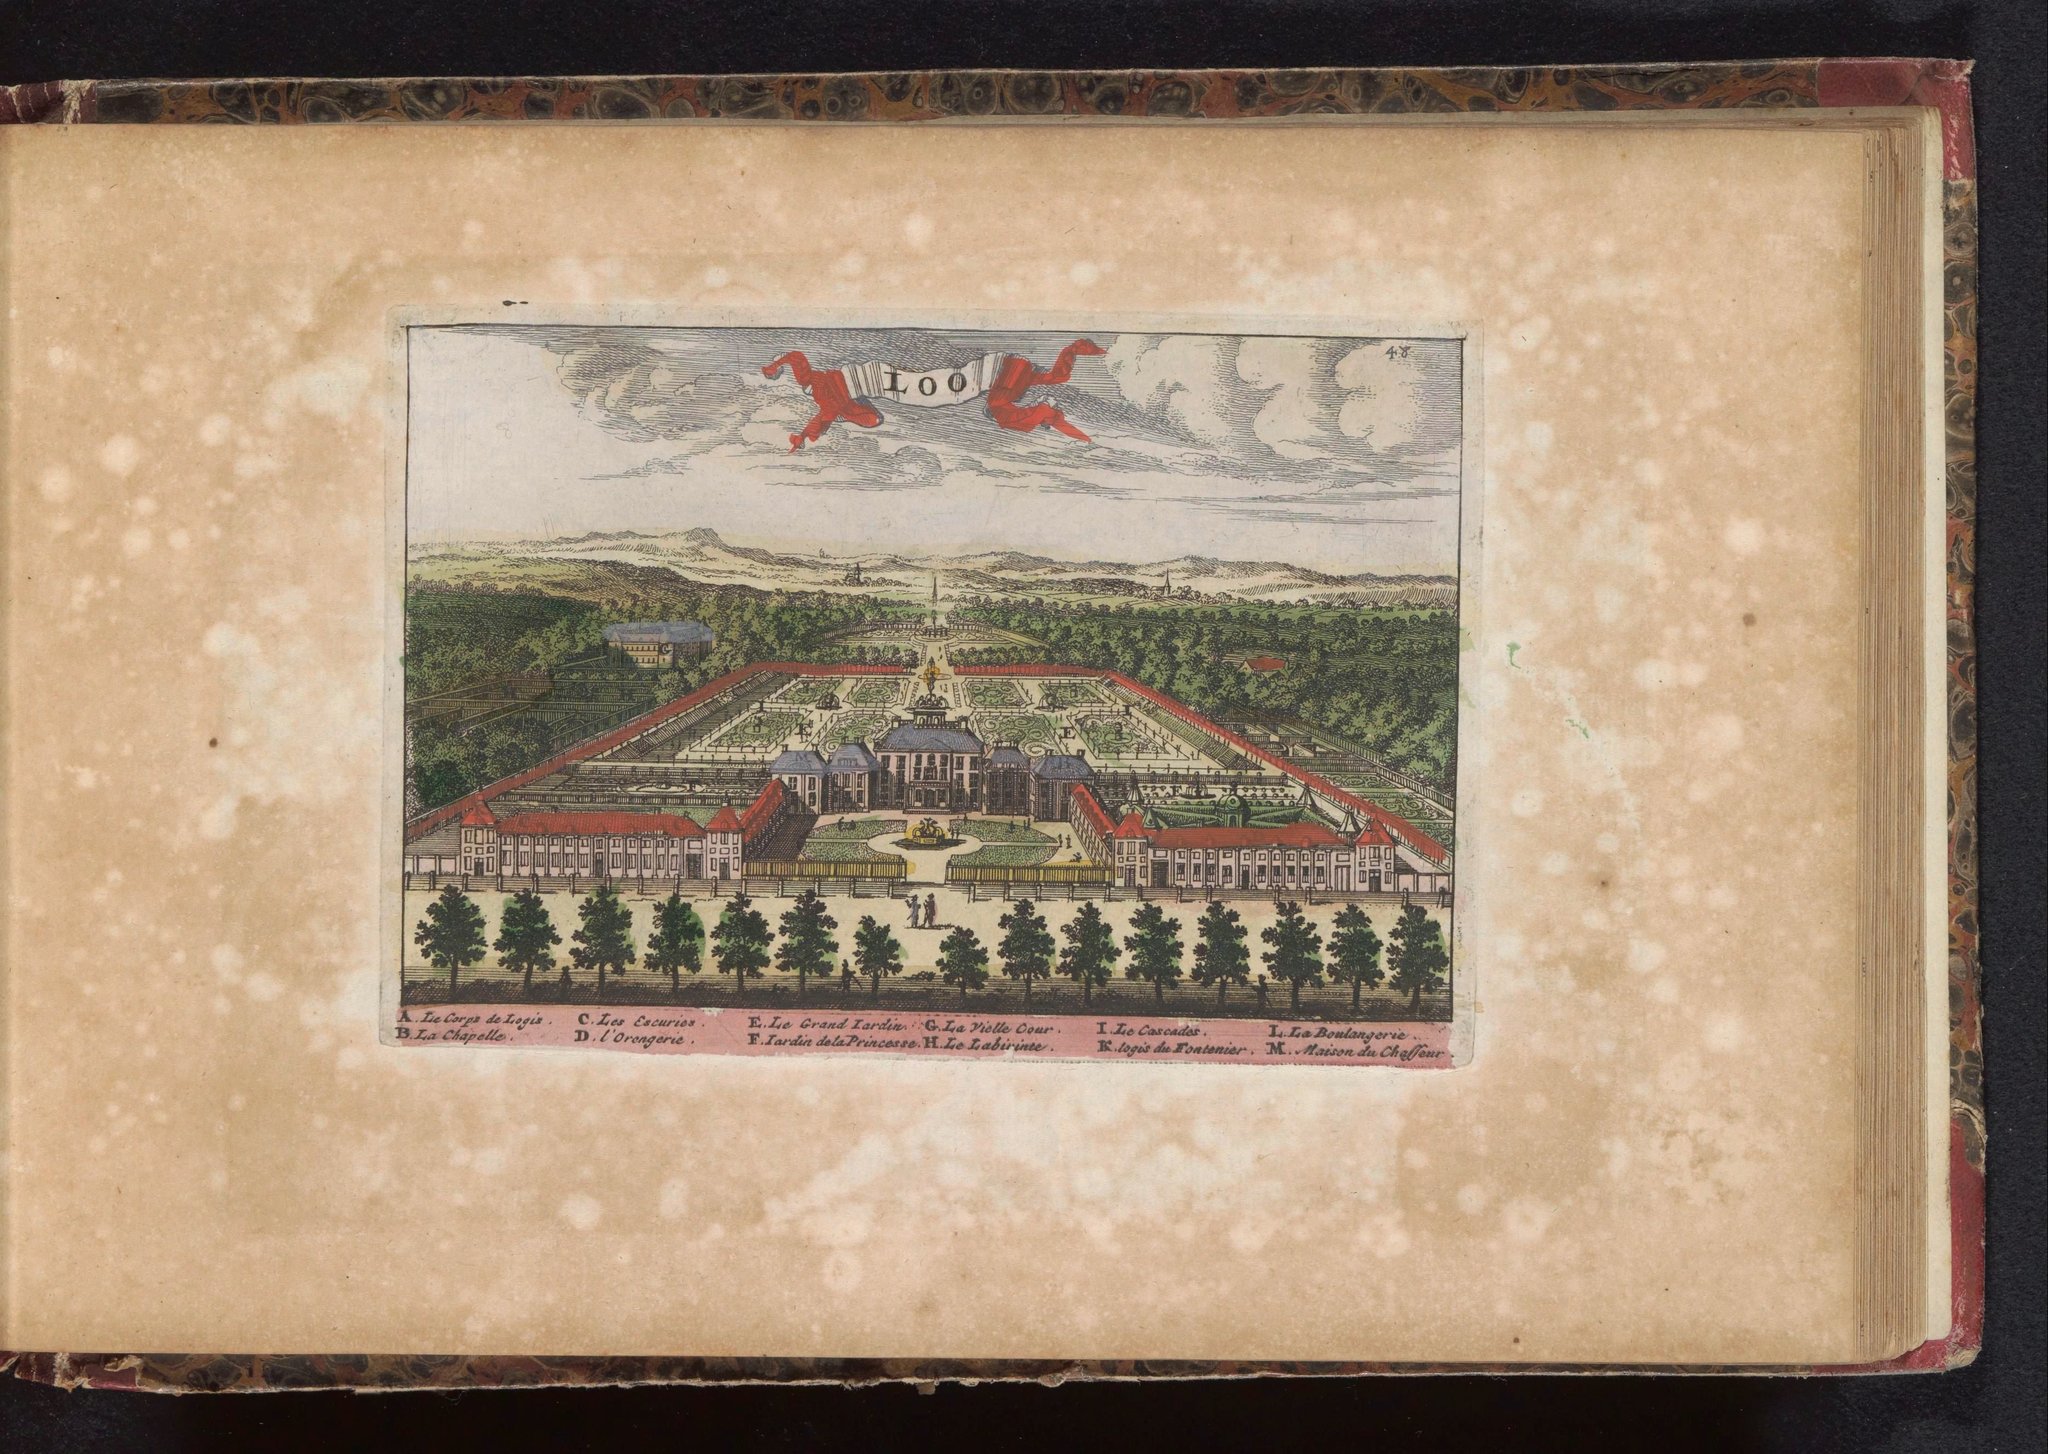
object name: print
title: Loo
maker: Anonymous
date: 1735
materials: paper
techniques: etching, hand coloring, lacquer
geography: amsterdam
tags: palace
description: Gezicht op Paleis Het Loo. In de marge de legenda A-M. Onderdeel van een atlas met 223 kaarten van landen en steden en oorlogstaferelen in Europa in de periode ca. 1690-1735.